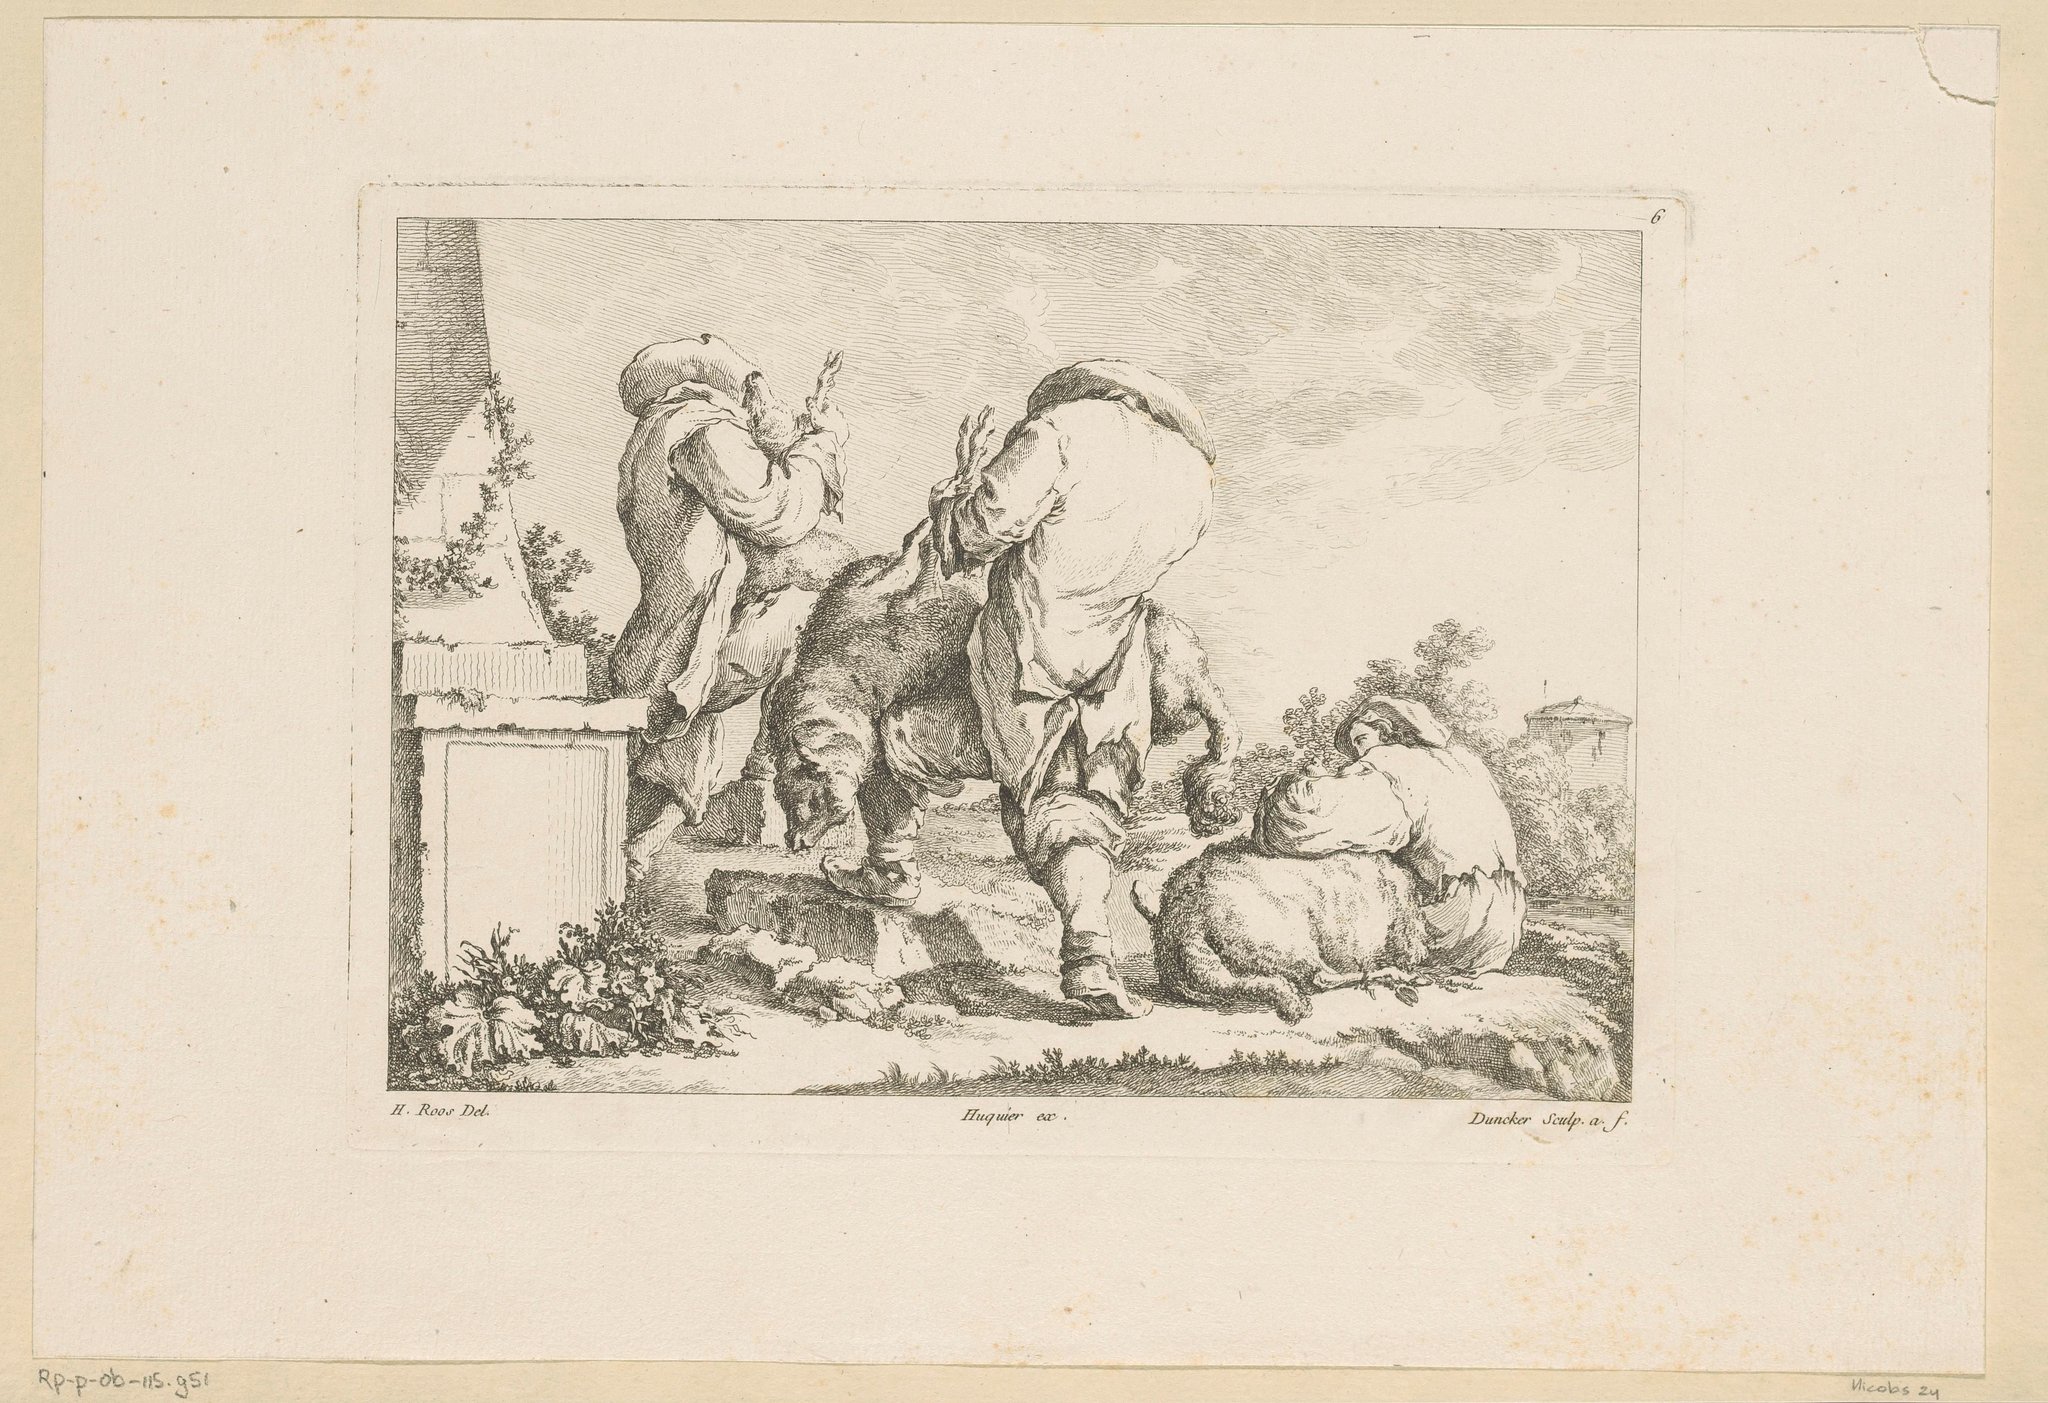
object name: print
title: Drie mannen vangen drie schapen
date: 1769-1772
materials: paper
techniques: etching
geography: paris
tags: adult man (+ three persons), sheep, catching animals, landscapes - hh - ideal landscapes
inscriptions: collector's mark: Lugt 240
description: Onderdeel van een serie van acht prenten.